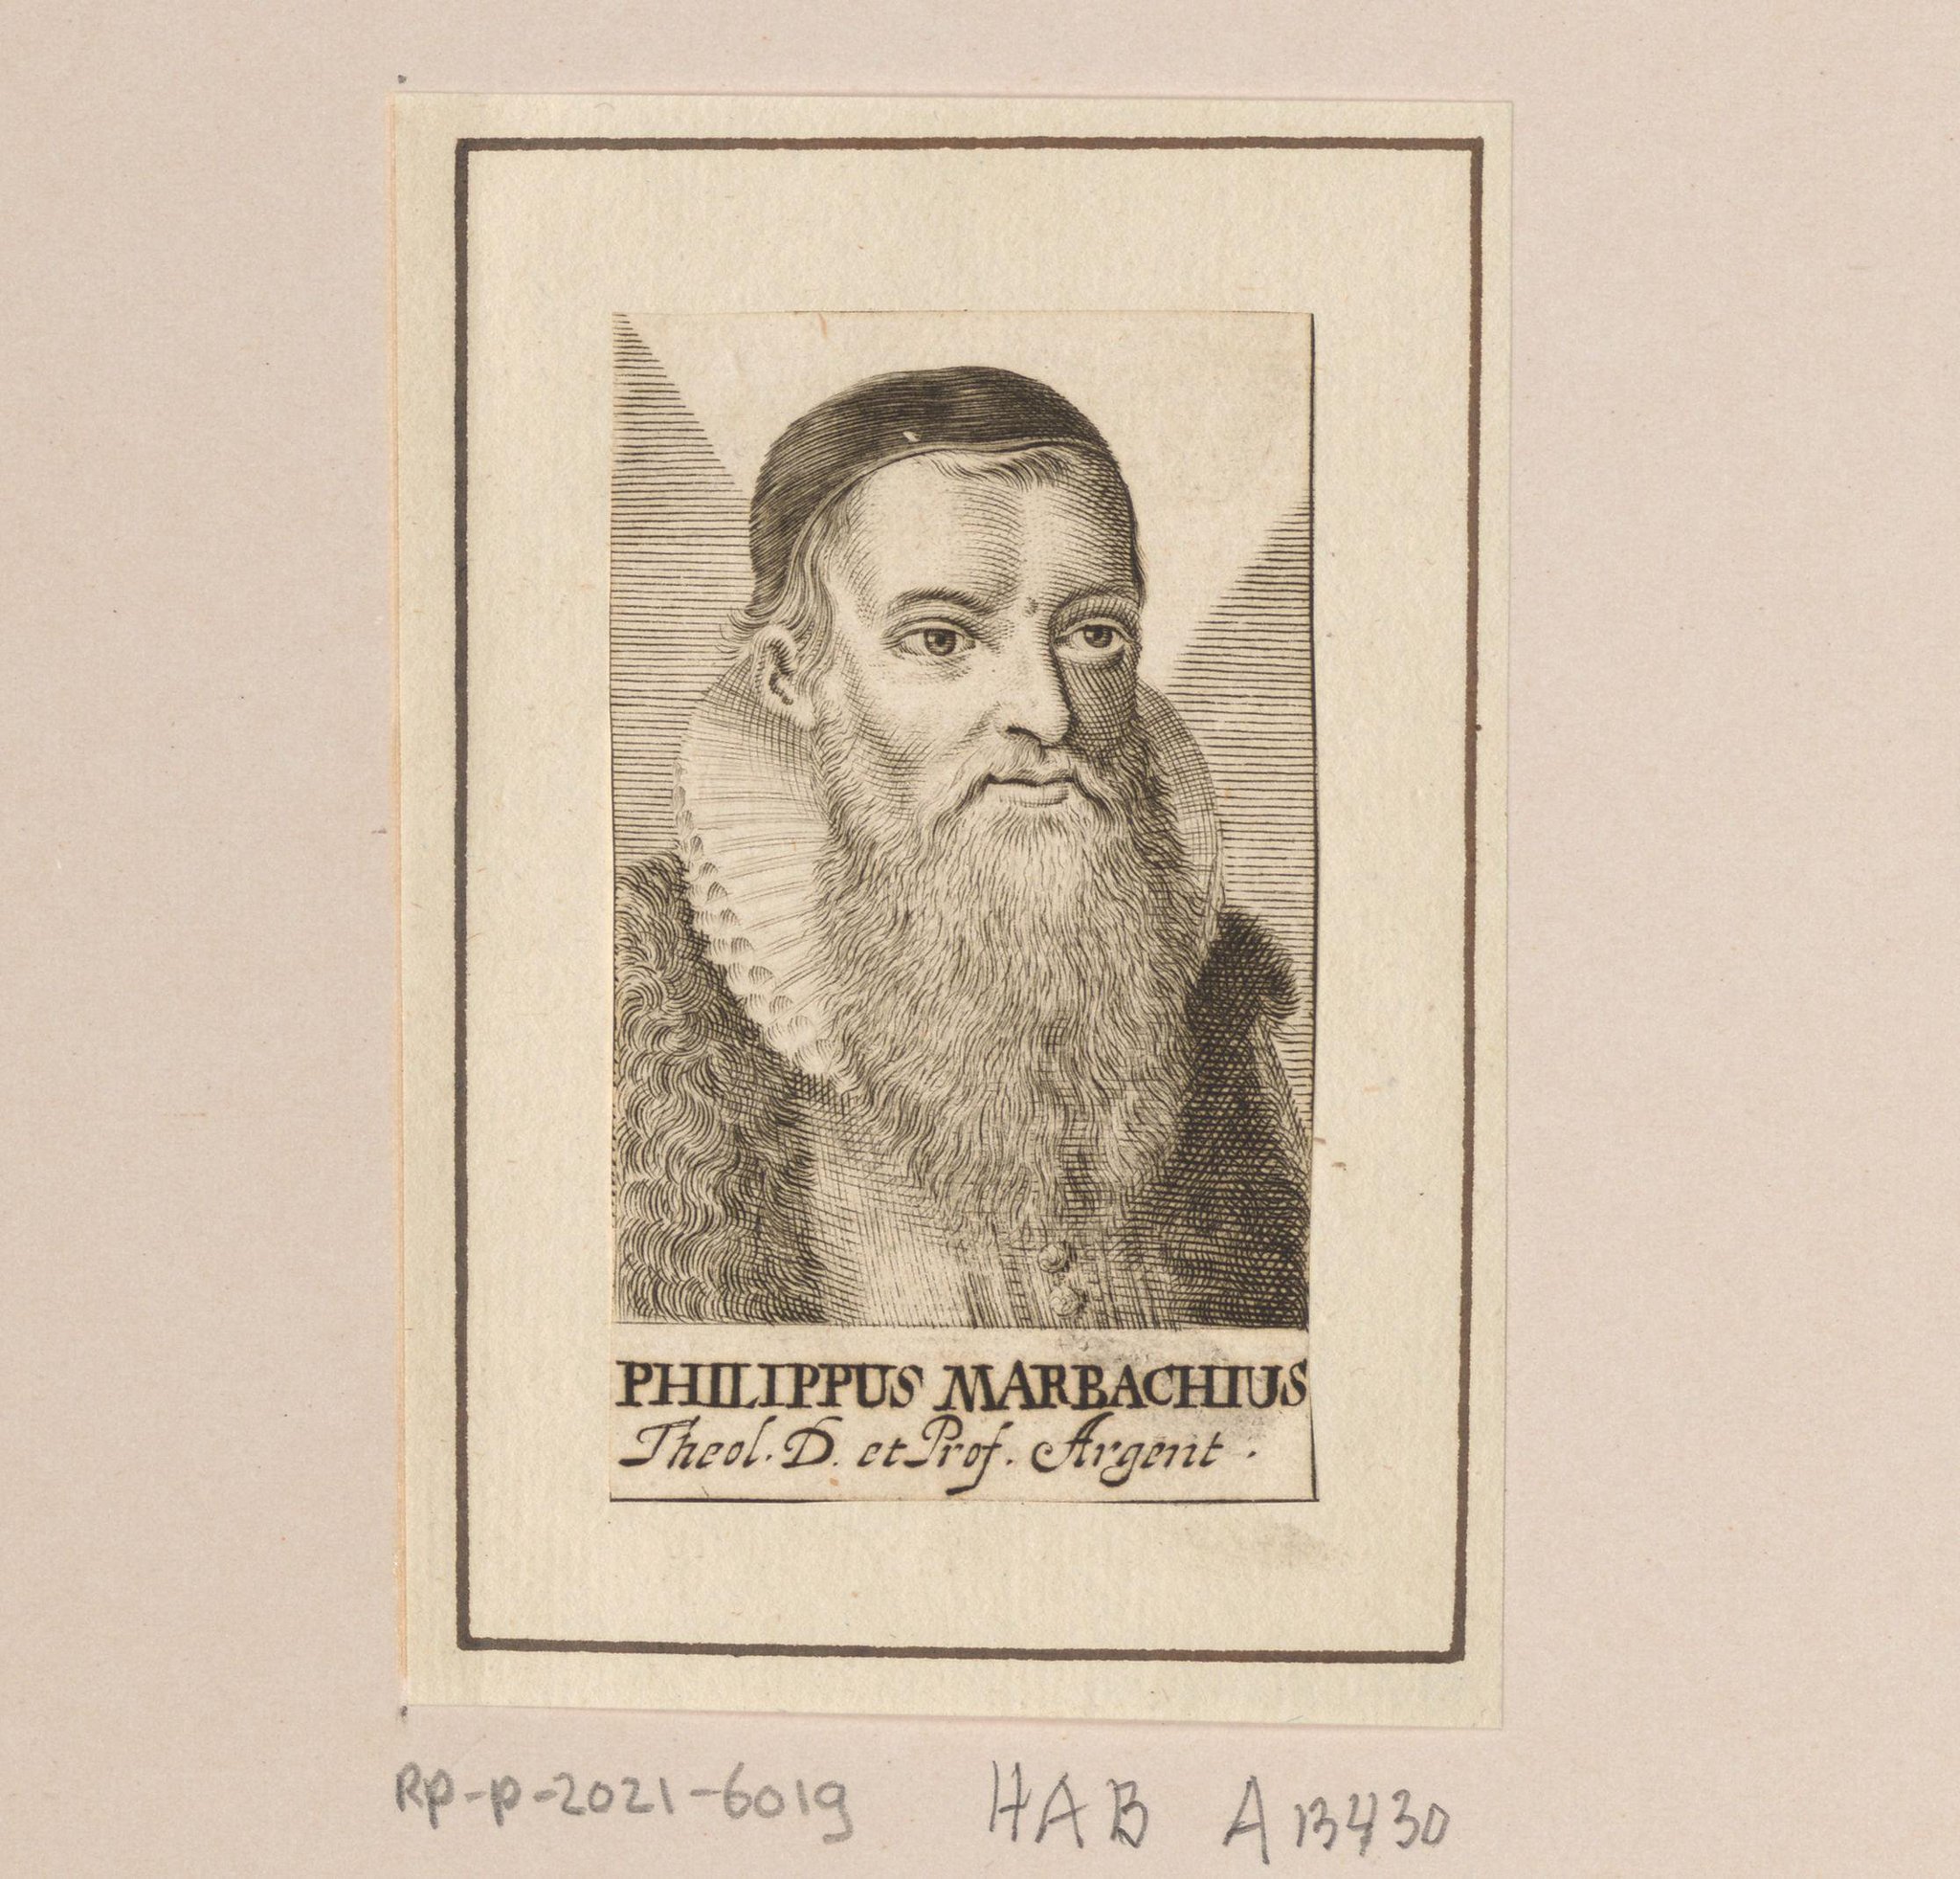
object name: print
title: Portret van Philipp Marbach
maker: johann franck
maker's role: print maker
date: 1688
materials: paper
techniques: engraving, snipping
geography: germany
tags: theologian, historical persons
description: Prent waarschijnlijk uit: Freher, Paul. Theatrum virorum eruditione clarorum. Neurenberg: Johann Hoffmann, 1688.